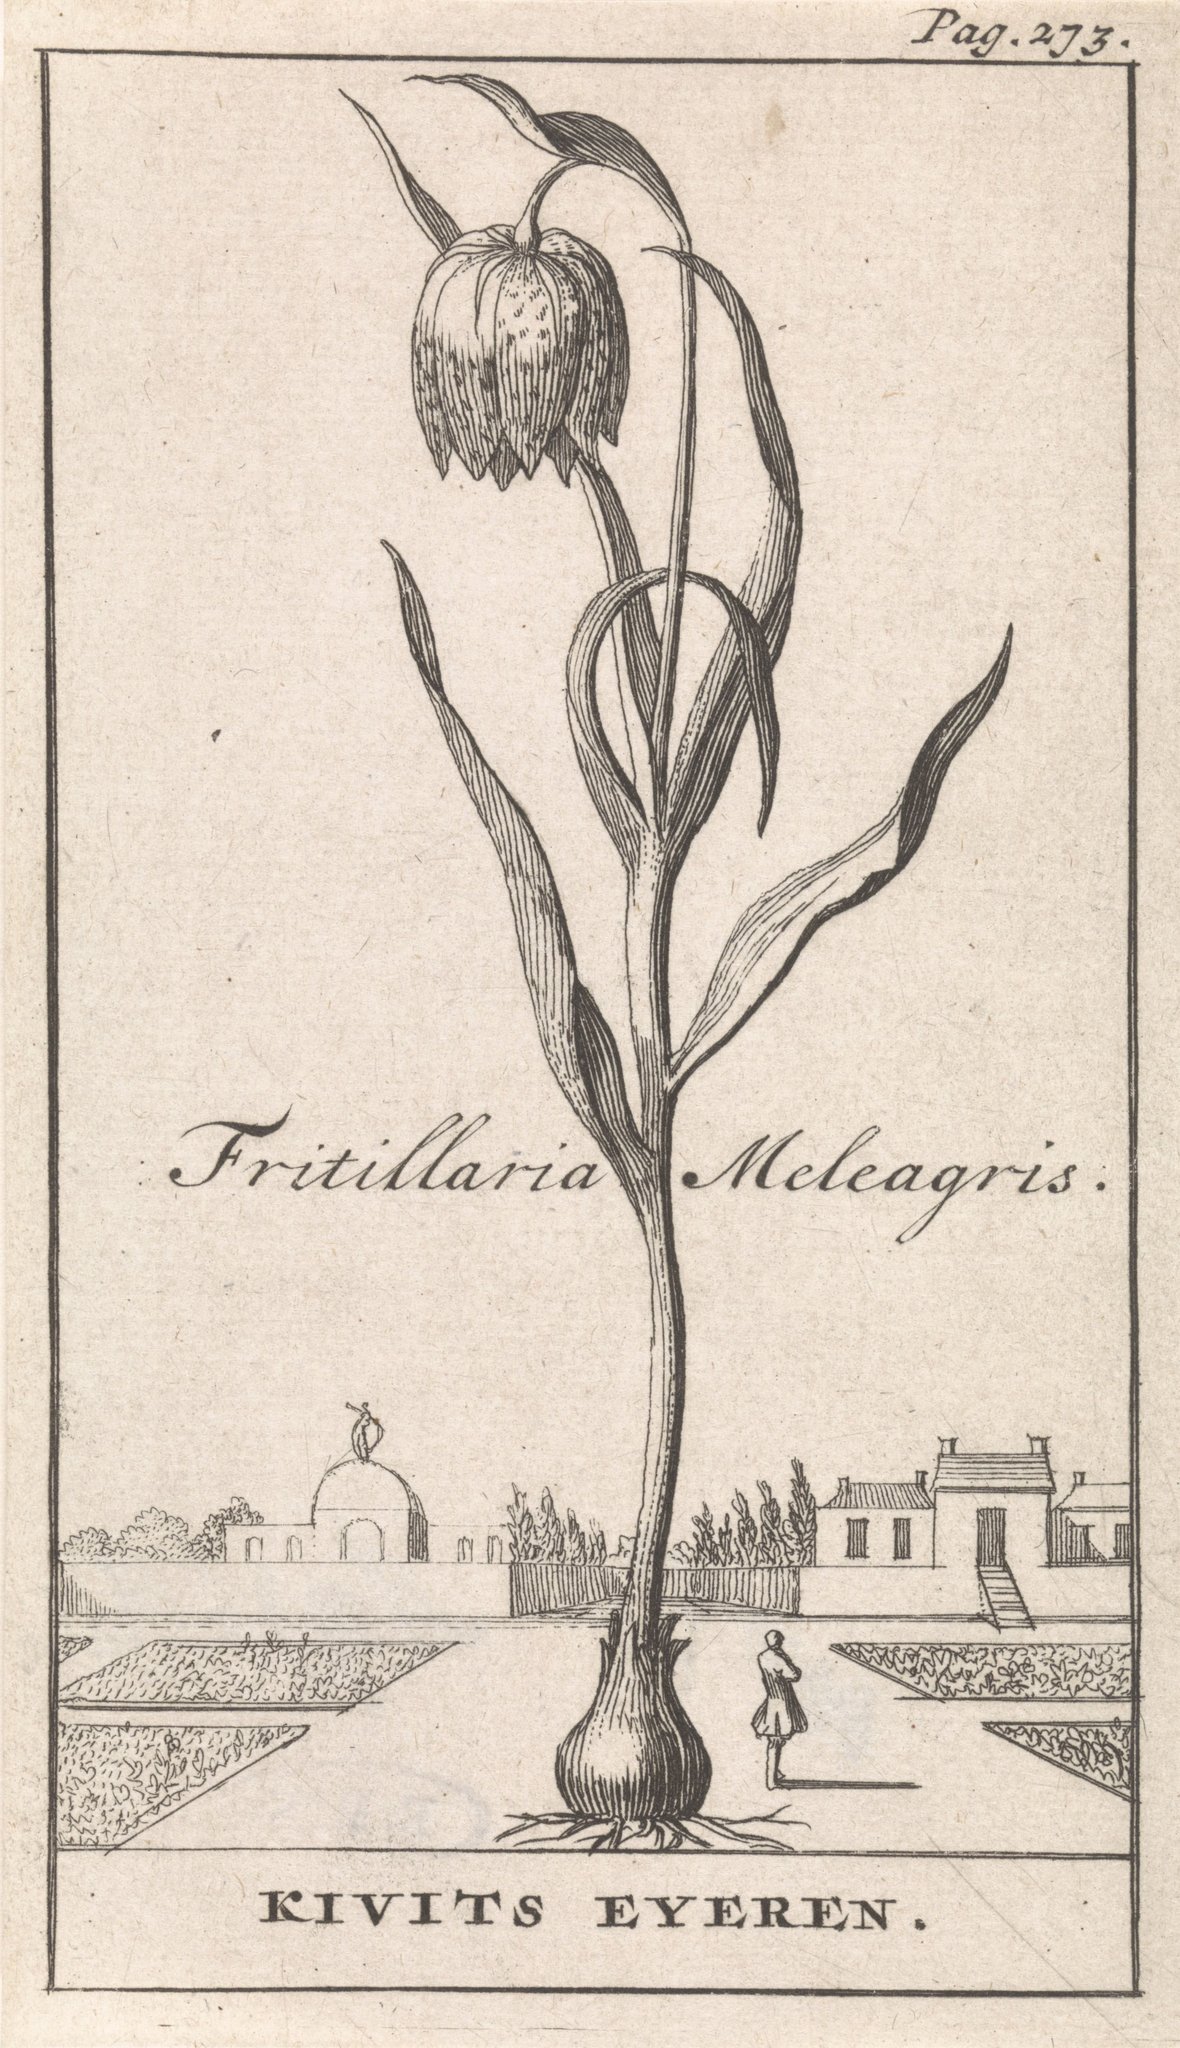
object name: print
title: Title Page and Eight Prints with Flowers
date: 1698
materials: paper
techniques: etching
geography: amsterdam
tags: plants and herbs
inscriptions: collector's mark: Lugt 2228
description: These floral prints by Jan Luyken are from the Nederlandschen Herbarius published by the physician Steven Blankaart in 1698. This Dutch herbal describes indigenous plants and trees with their medicinal properties. Incidentally, not all flowers had a practical medical application. But they were quite suitable ‘to make nosegays and posies’ or ‘simply a pleasure to look at’.